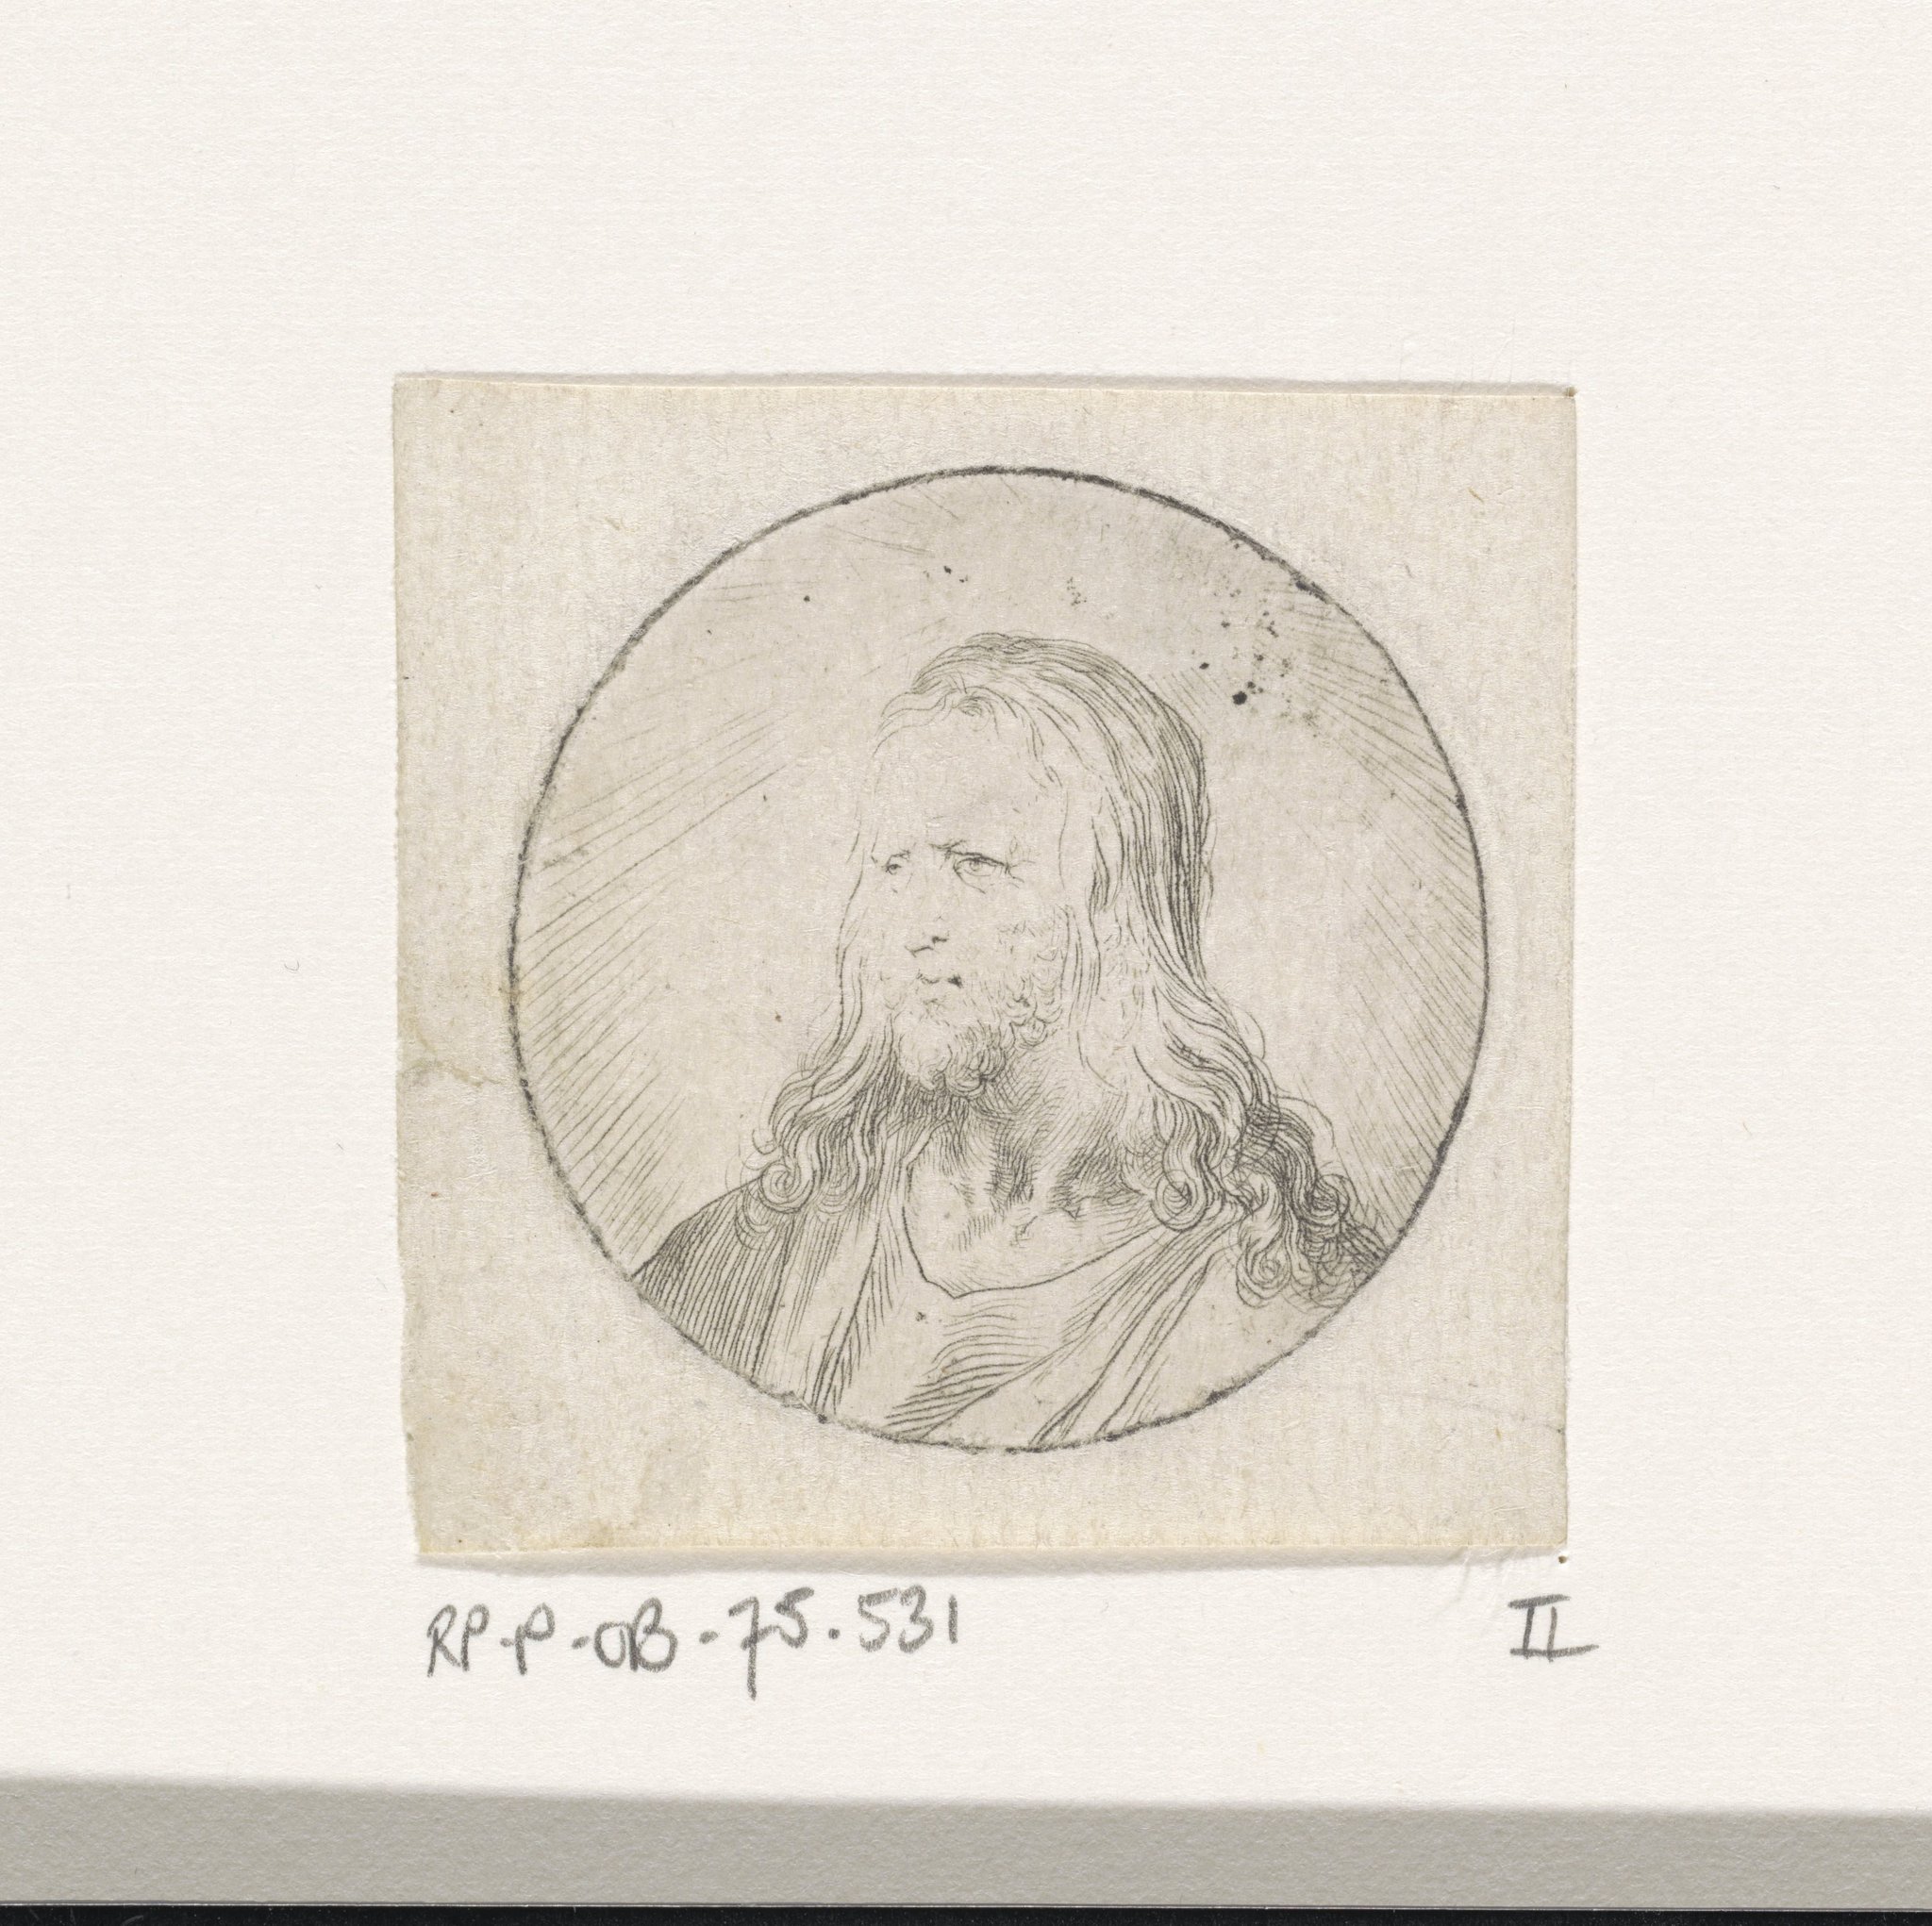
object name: print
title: Buste van Christus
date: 1600-1850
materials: paper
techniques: engraving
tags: 'portraits' of christ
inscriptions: collector's mark: Lugt 240